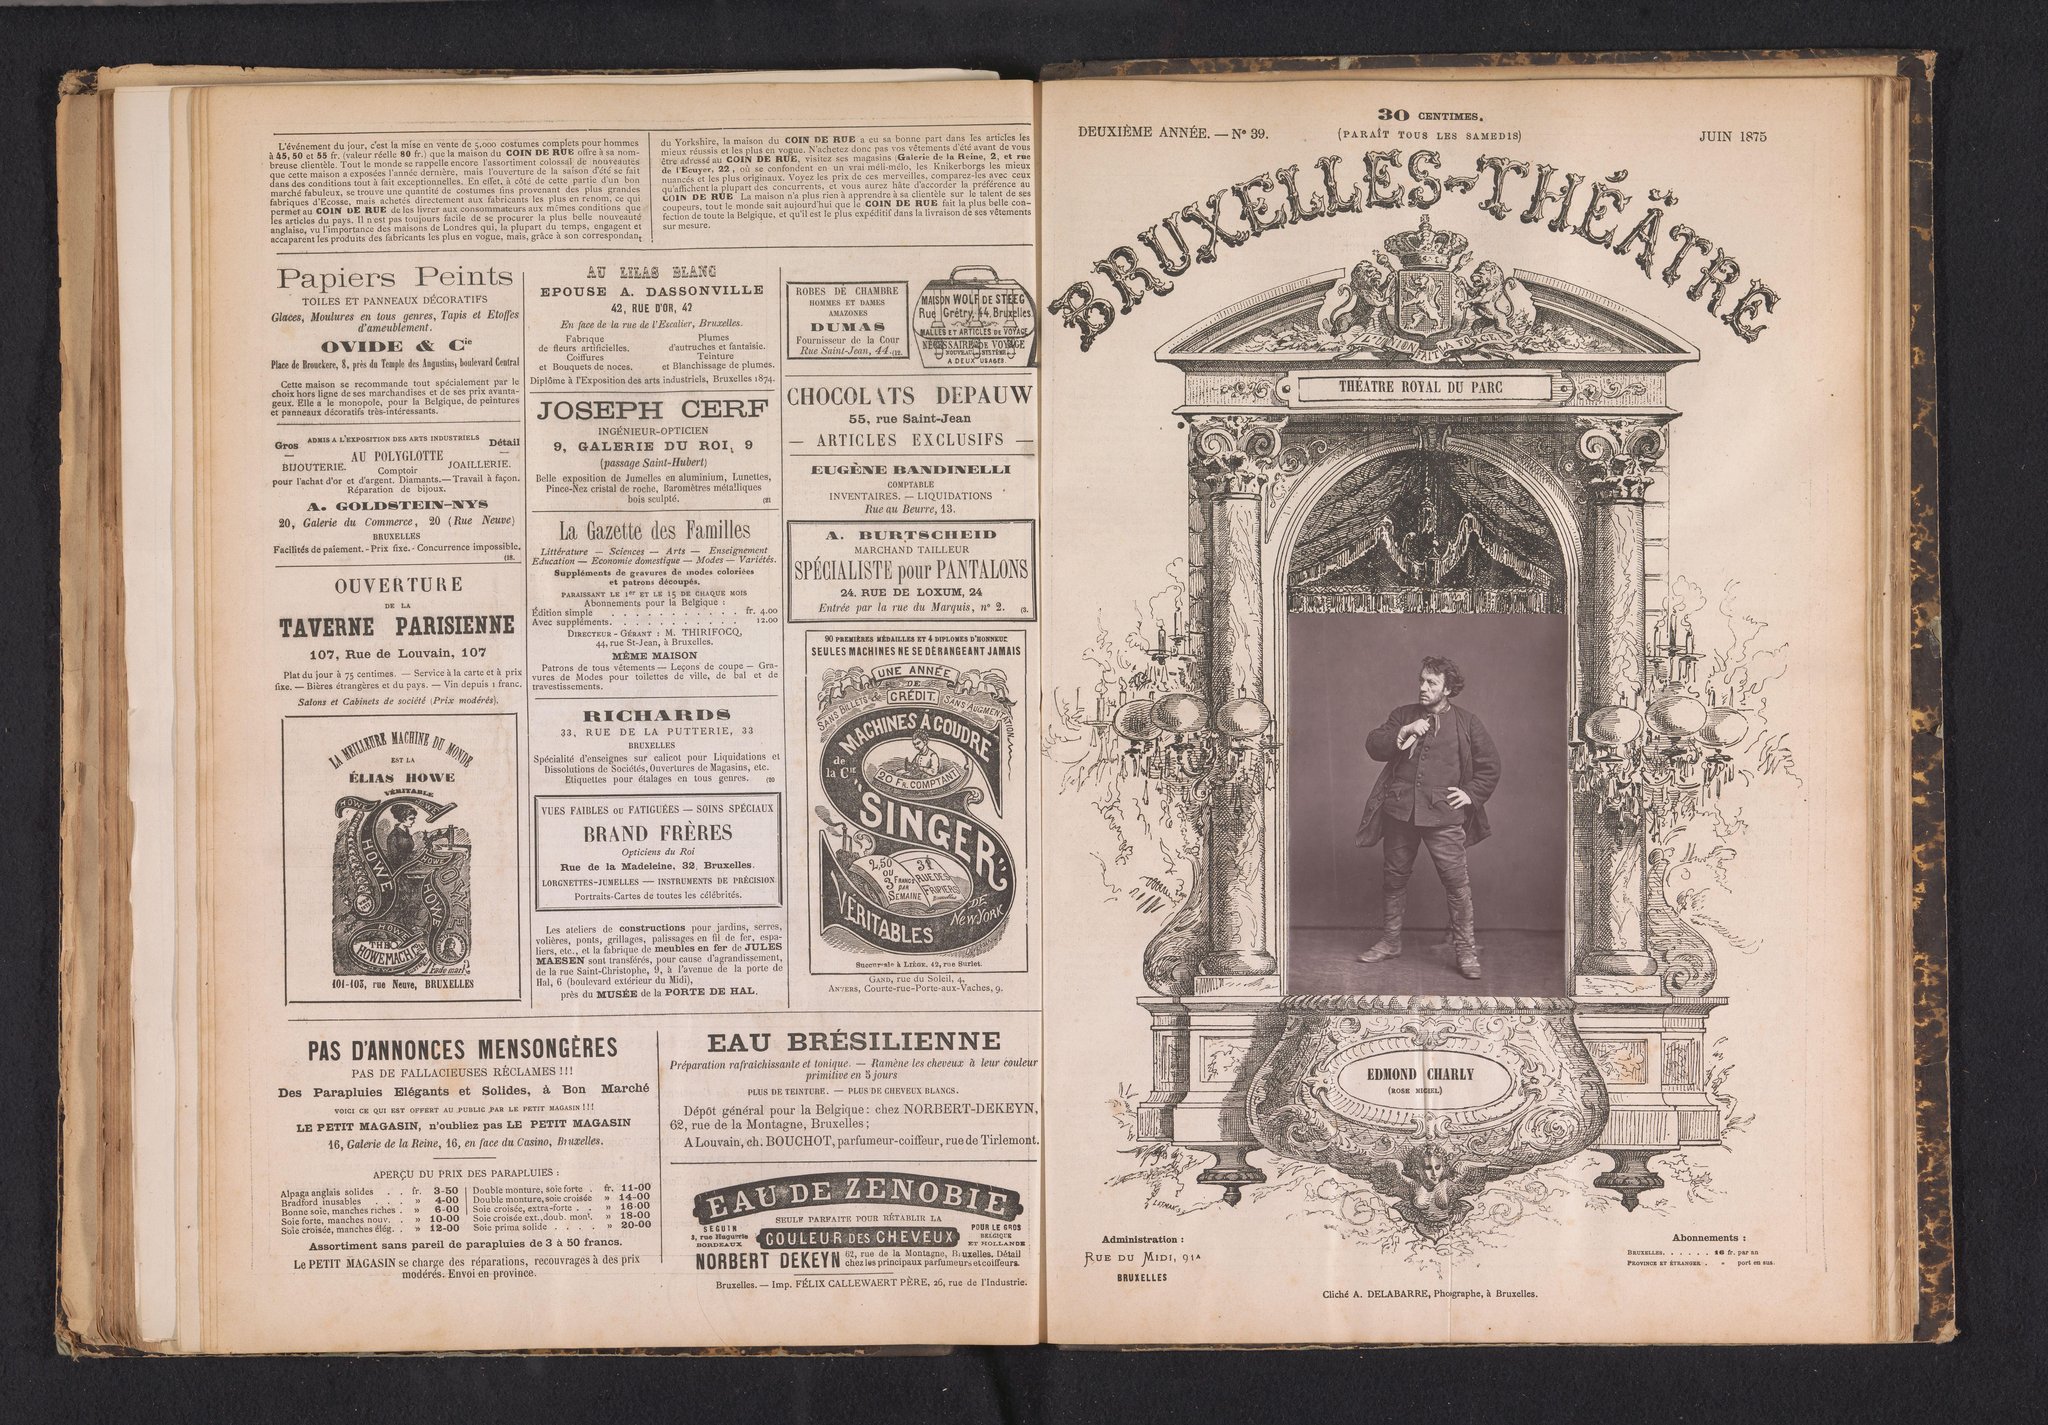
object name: photomechanical print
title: Edmond Charly (Rose Michel)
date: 1870-1875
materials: paper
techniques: woodburytype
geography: brussels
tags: portrait of actor, actress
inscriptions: number: ‘No 39.’